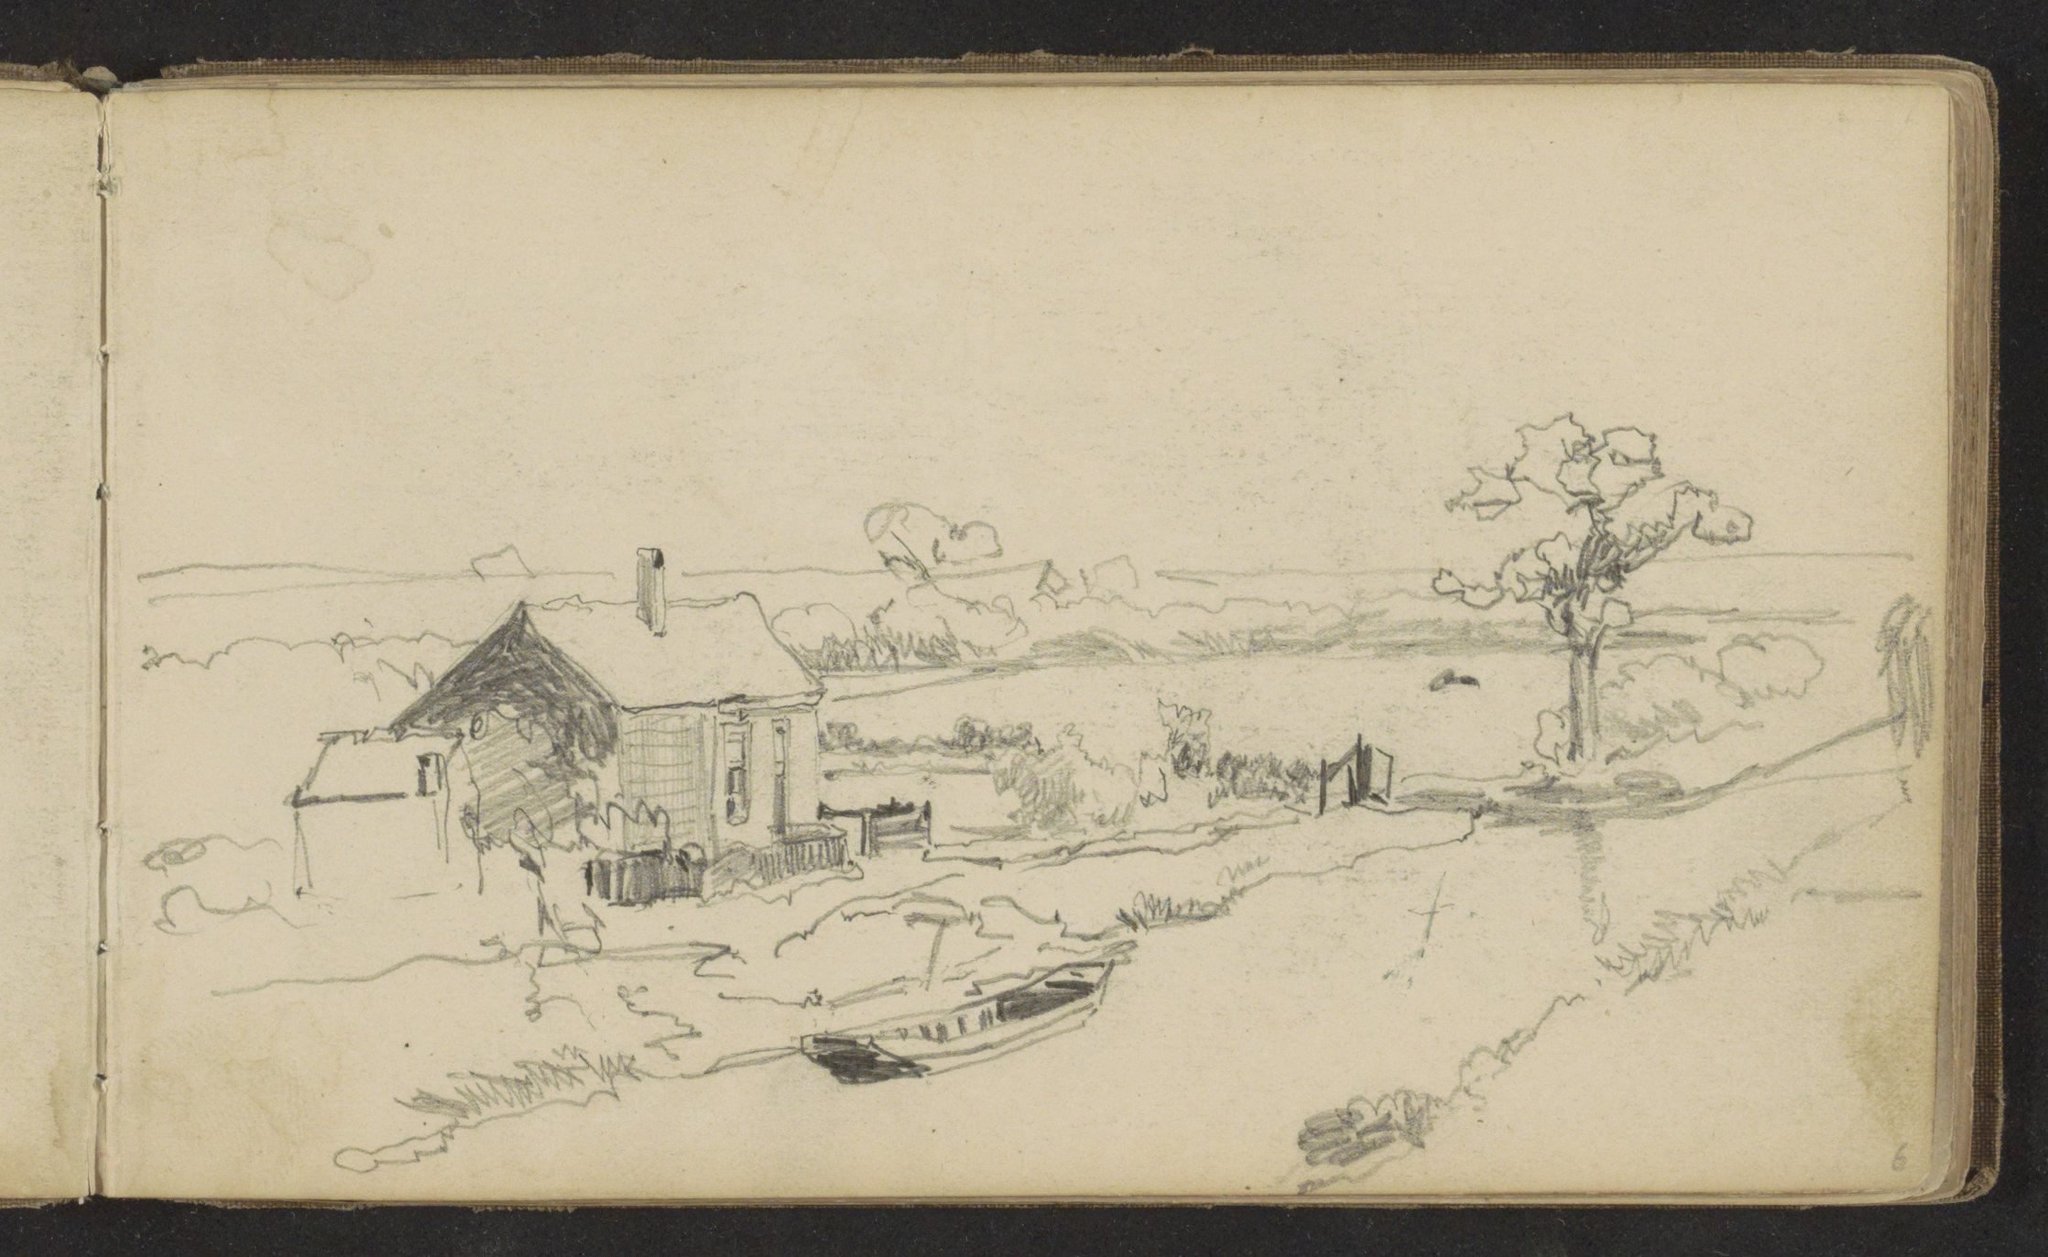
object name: sketchbook leaf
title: Boerenwoning aan een vaart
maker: johan hendrik weissenbruch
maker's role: draughtsman, painter, print maker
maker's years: 1824-1903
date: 1834-1903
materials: paper, pencil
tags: canal, cottage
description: Aan de waterkant ligt een boot aangemeerd. Blad 6 recto uit een schetsboek met 43 bladen.